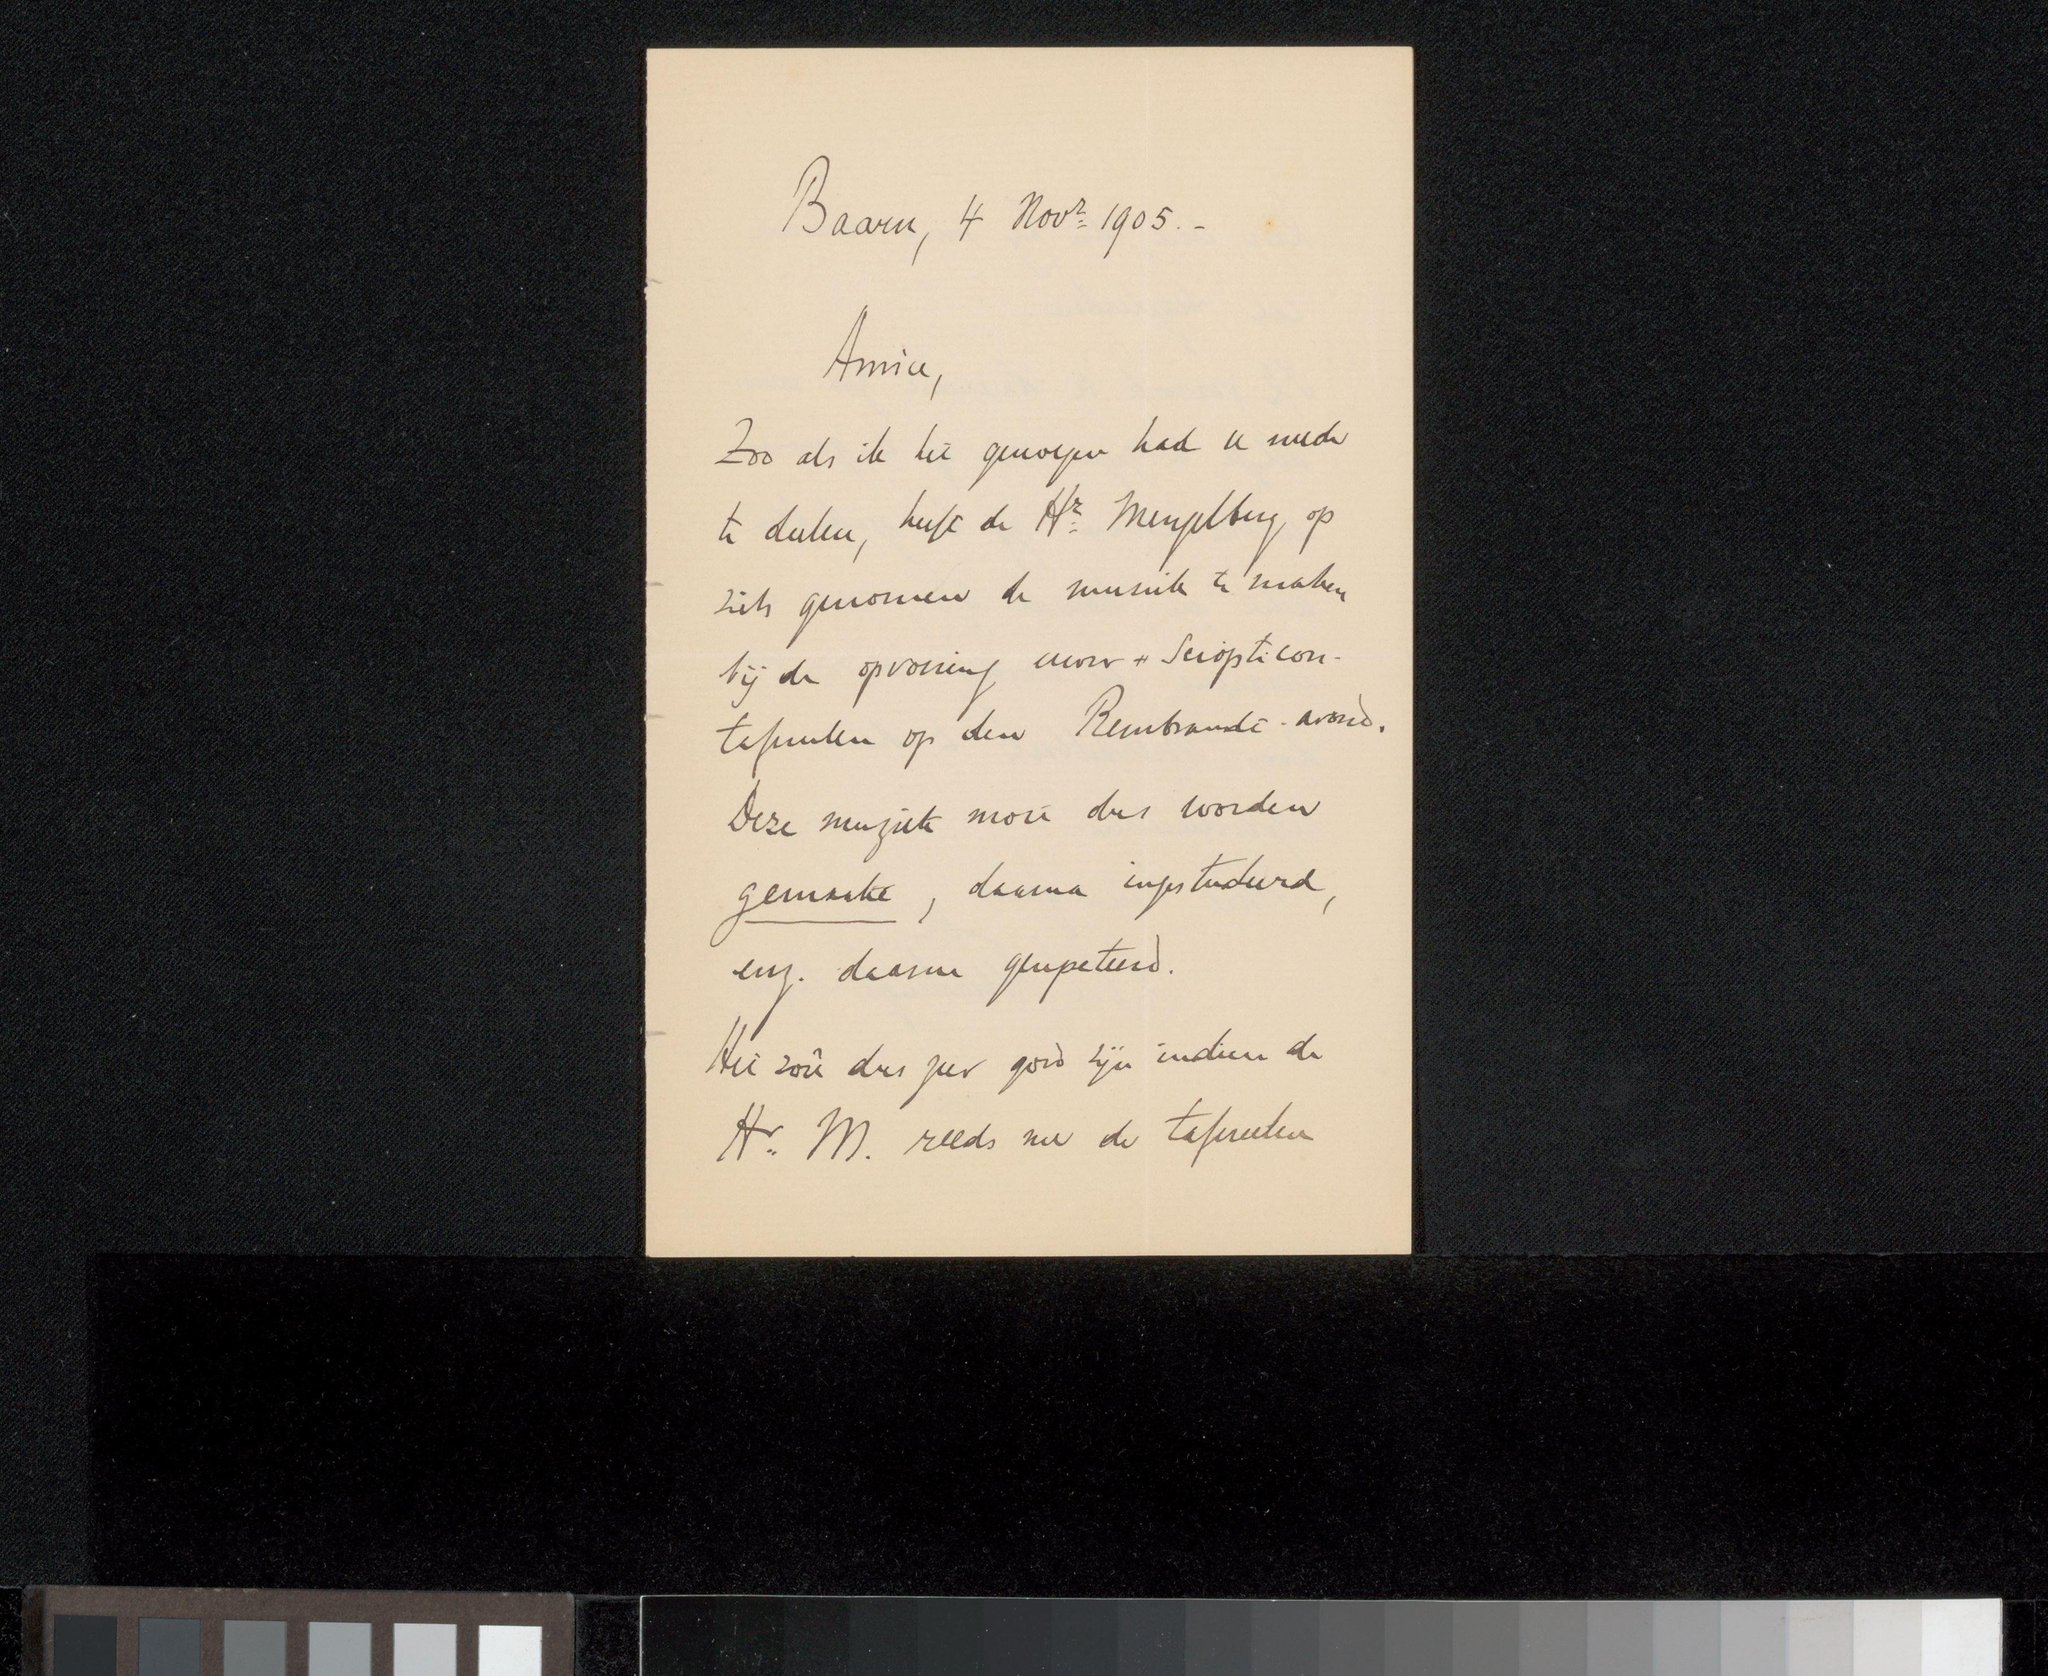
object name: letter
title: Brief aan Jan Veth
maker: karel johan lodewijk alberdingk thijm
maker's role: criticus, prozaschrijver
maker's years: 1864-1952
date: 1905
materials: ink, paper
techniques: pen, writing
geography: baarn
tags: dordrecht, amsterdam, painter, print maker, draughtsman, designer, jan veth, jacob merkelbach, utrecht, music, the graphic arts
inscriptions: watermark, collector's mark: ‘RPK’